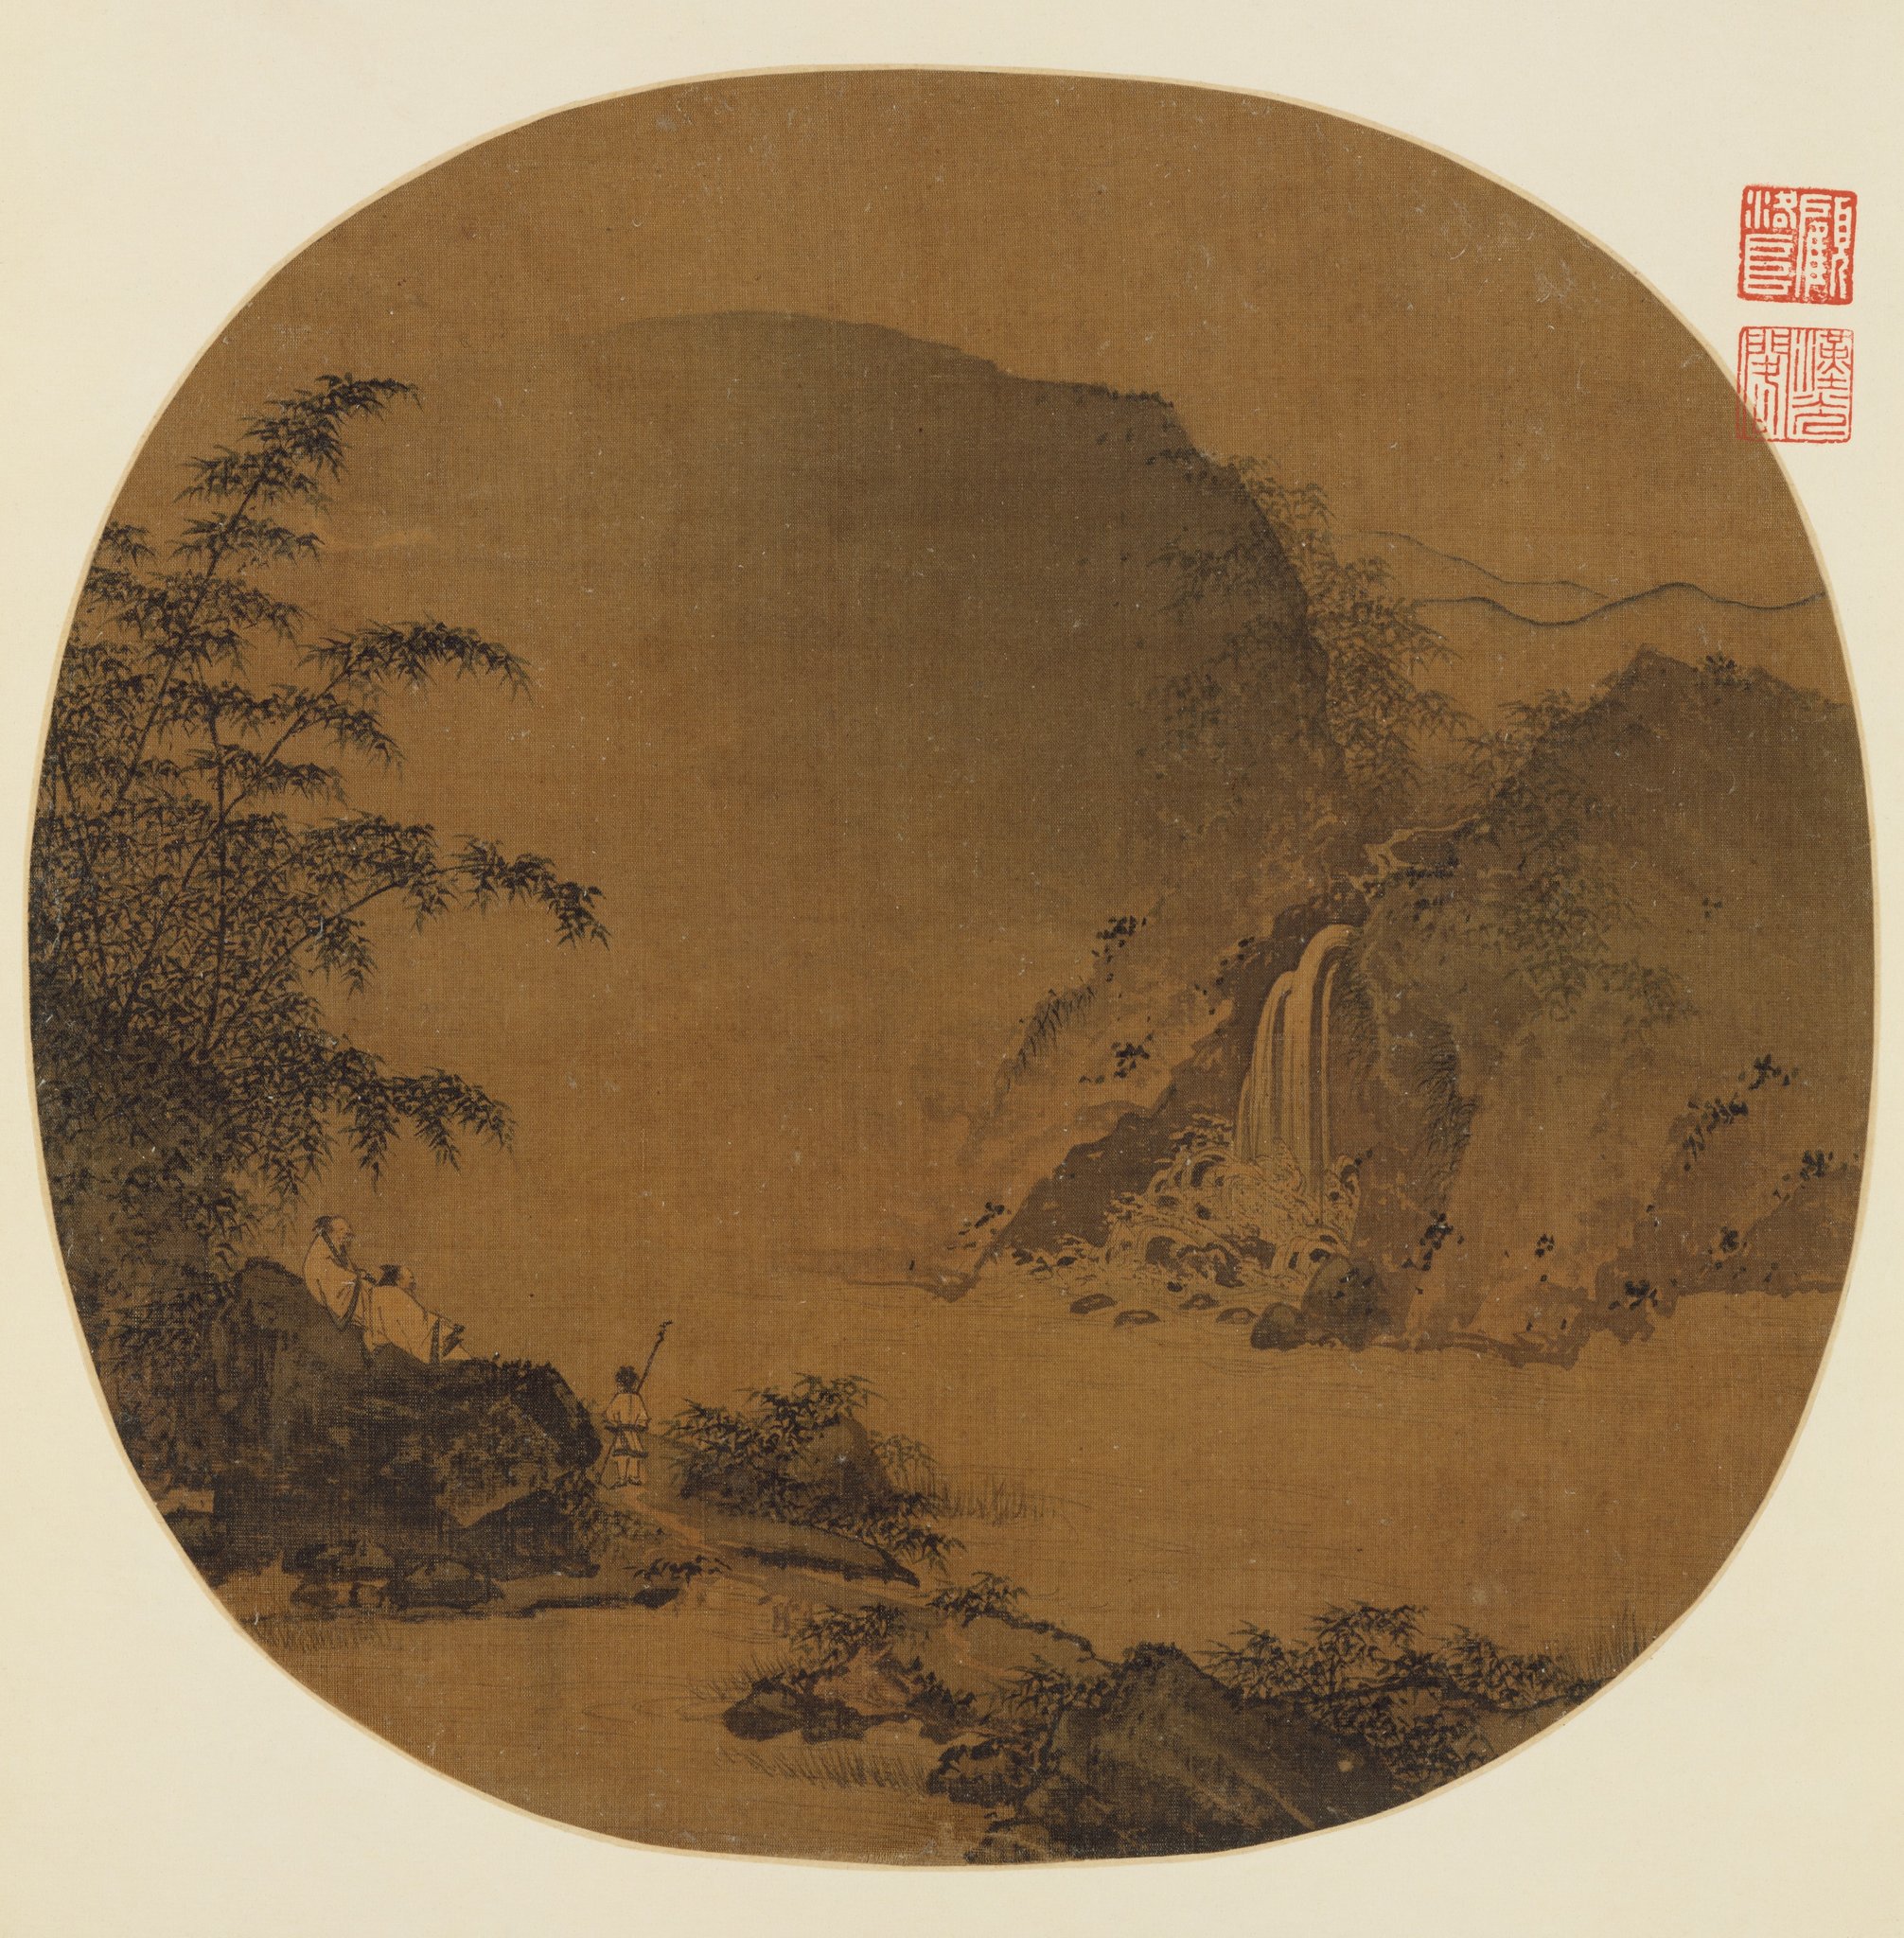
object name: fan mounted a an album leaf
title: Gentlemen gazing at a waterfall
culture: chinese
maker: unidentified artist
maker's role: artist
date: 1201-1300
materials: ink, silk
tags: waterfalls,landscapes